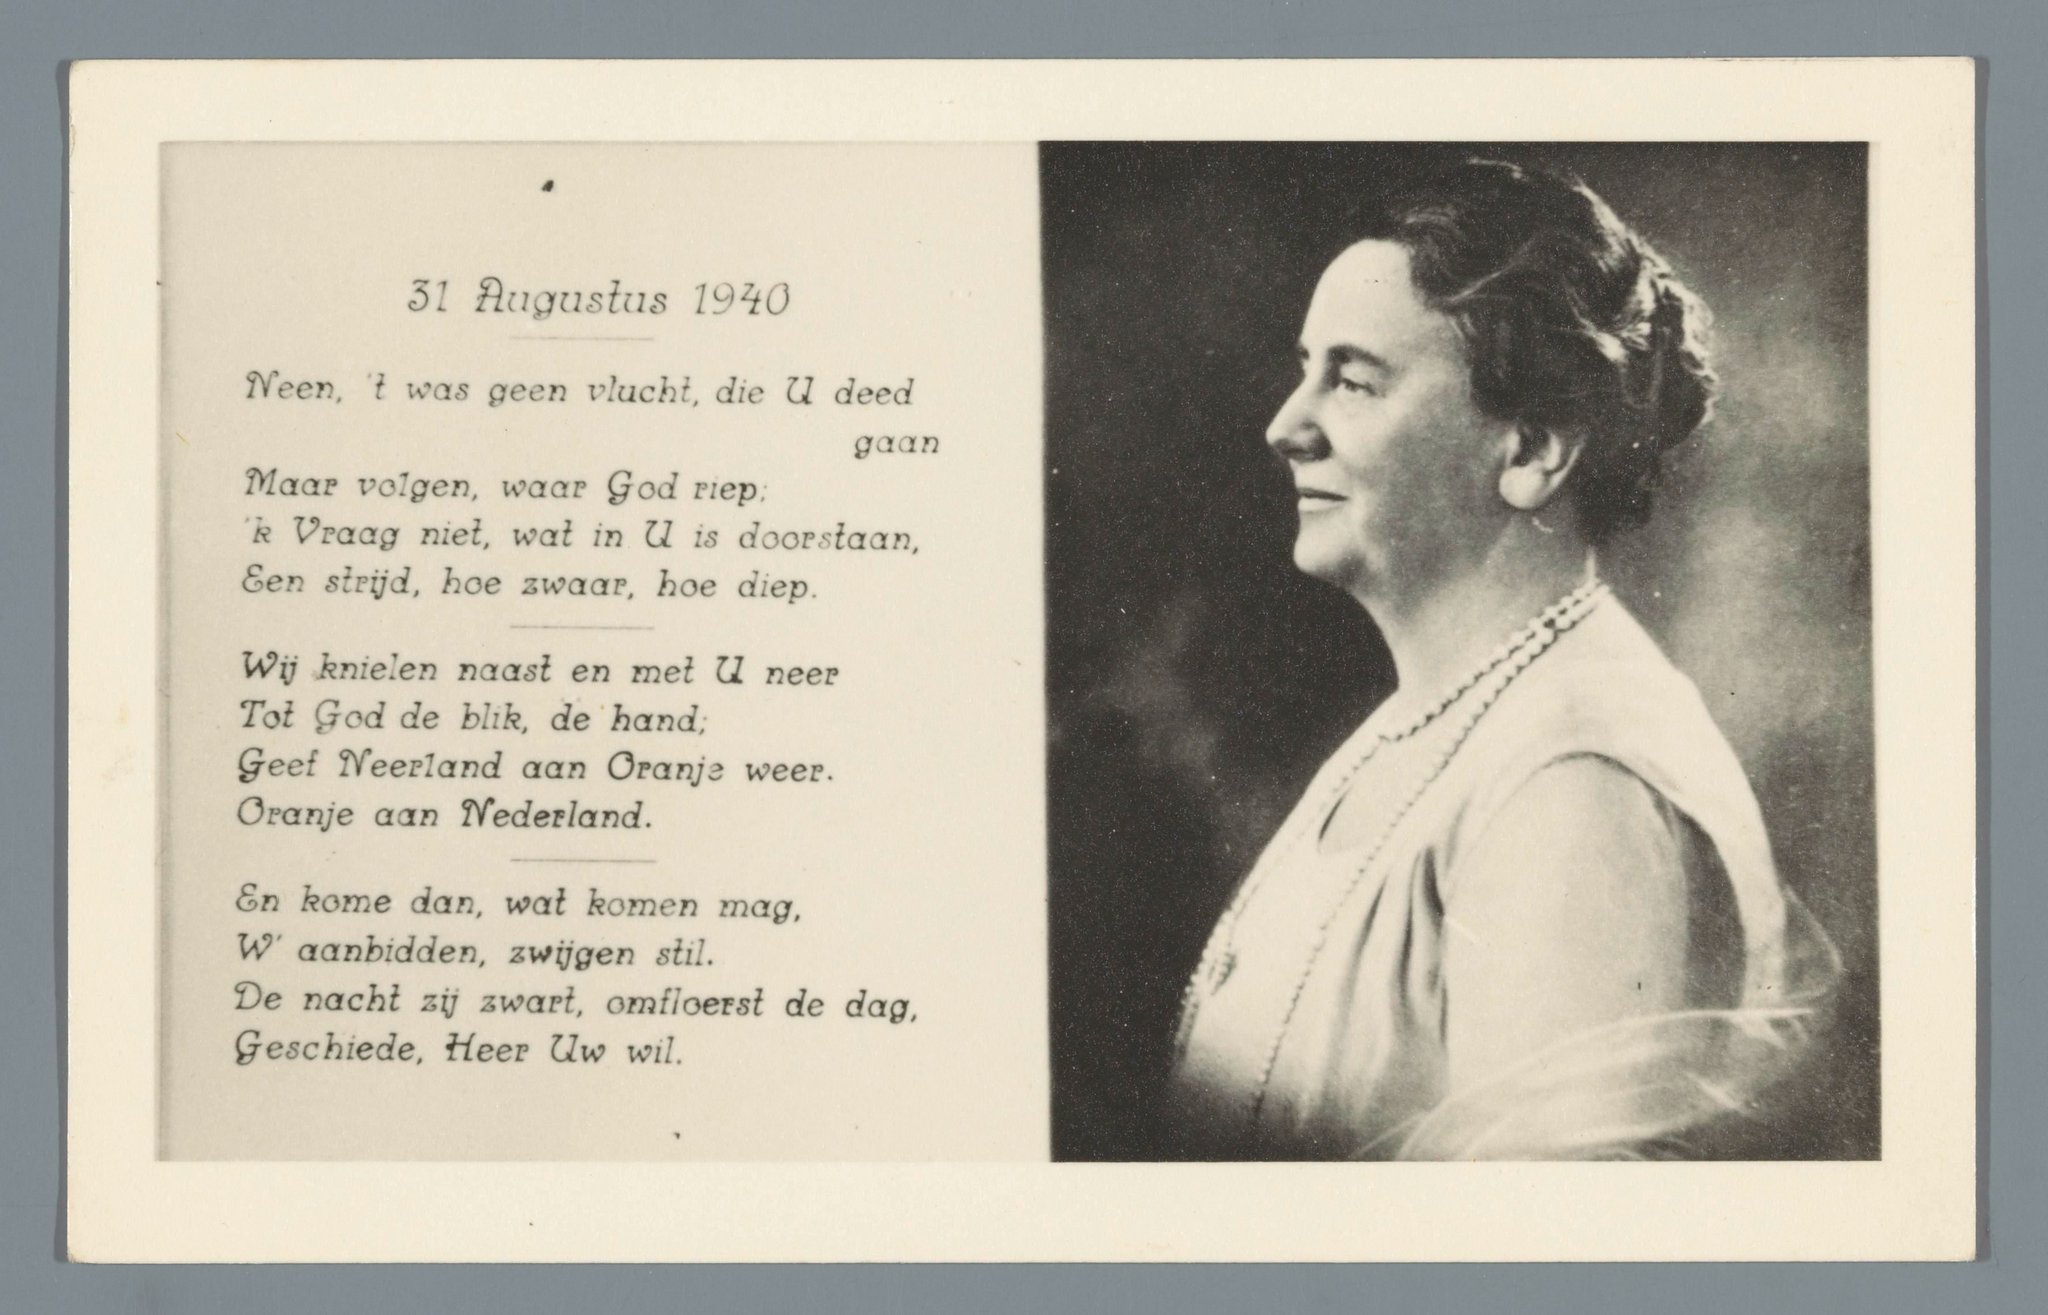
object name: ansichtkaart, prentbriefkaart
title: Portret van koningin Wilhelmina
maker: Anonymous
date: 1940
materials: photographic support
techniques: gelatin silver print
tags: the hague, wilhelmina of the netherlands, historical persons, queen